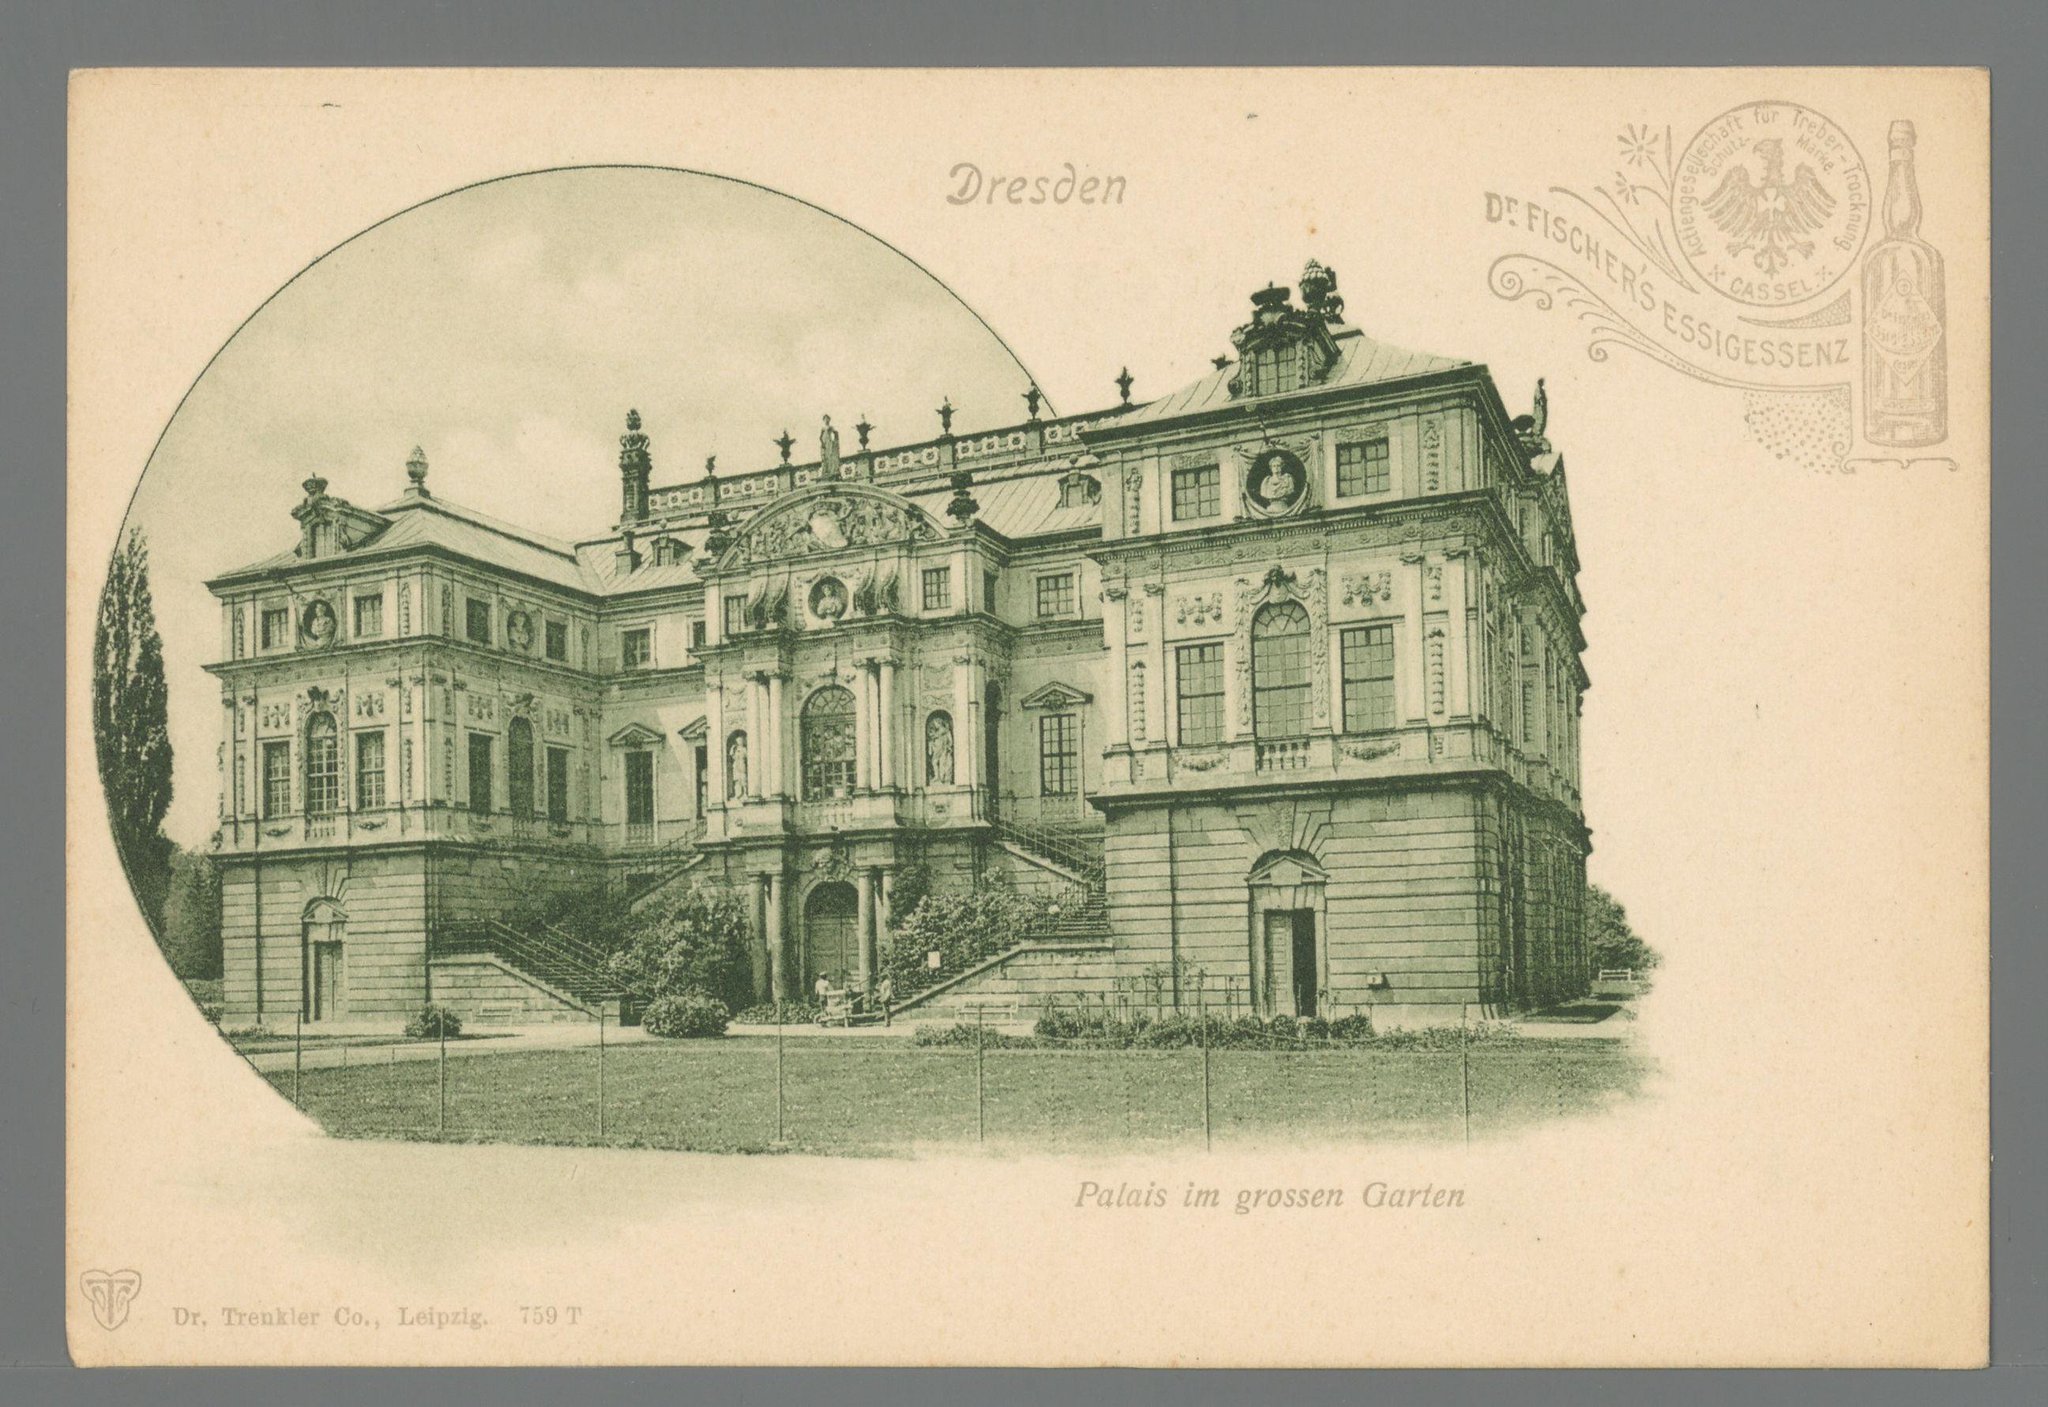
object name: photomechanical print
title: Dresden. Palais im grossen Garten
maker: Anonymous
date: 1895-1901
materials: cardboard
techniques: photograph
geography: leipzig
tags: palace